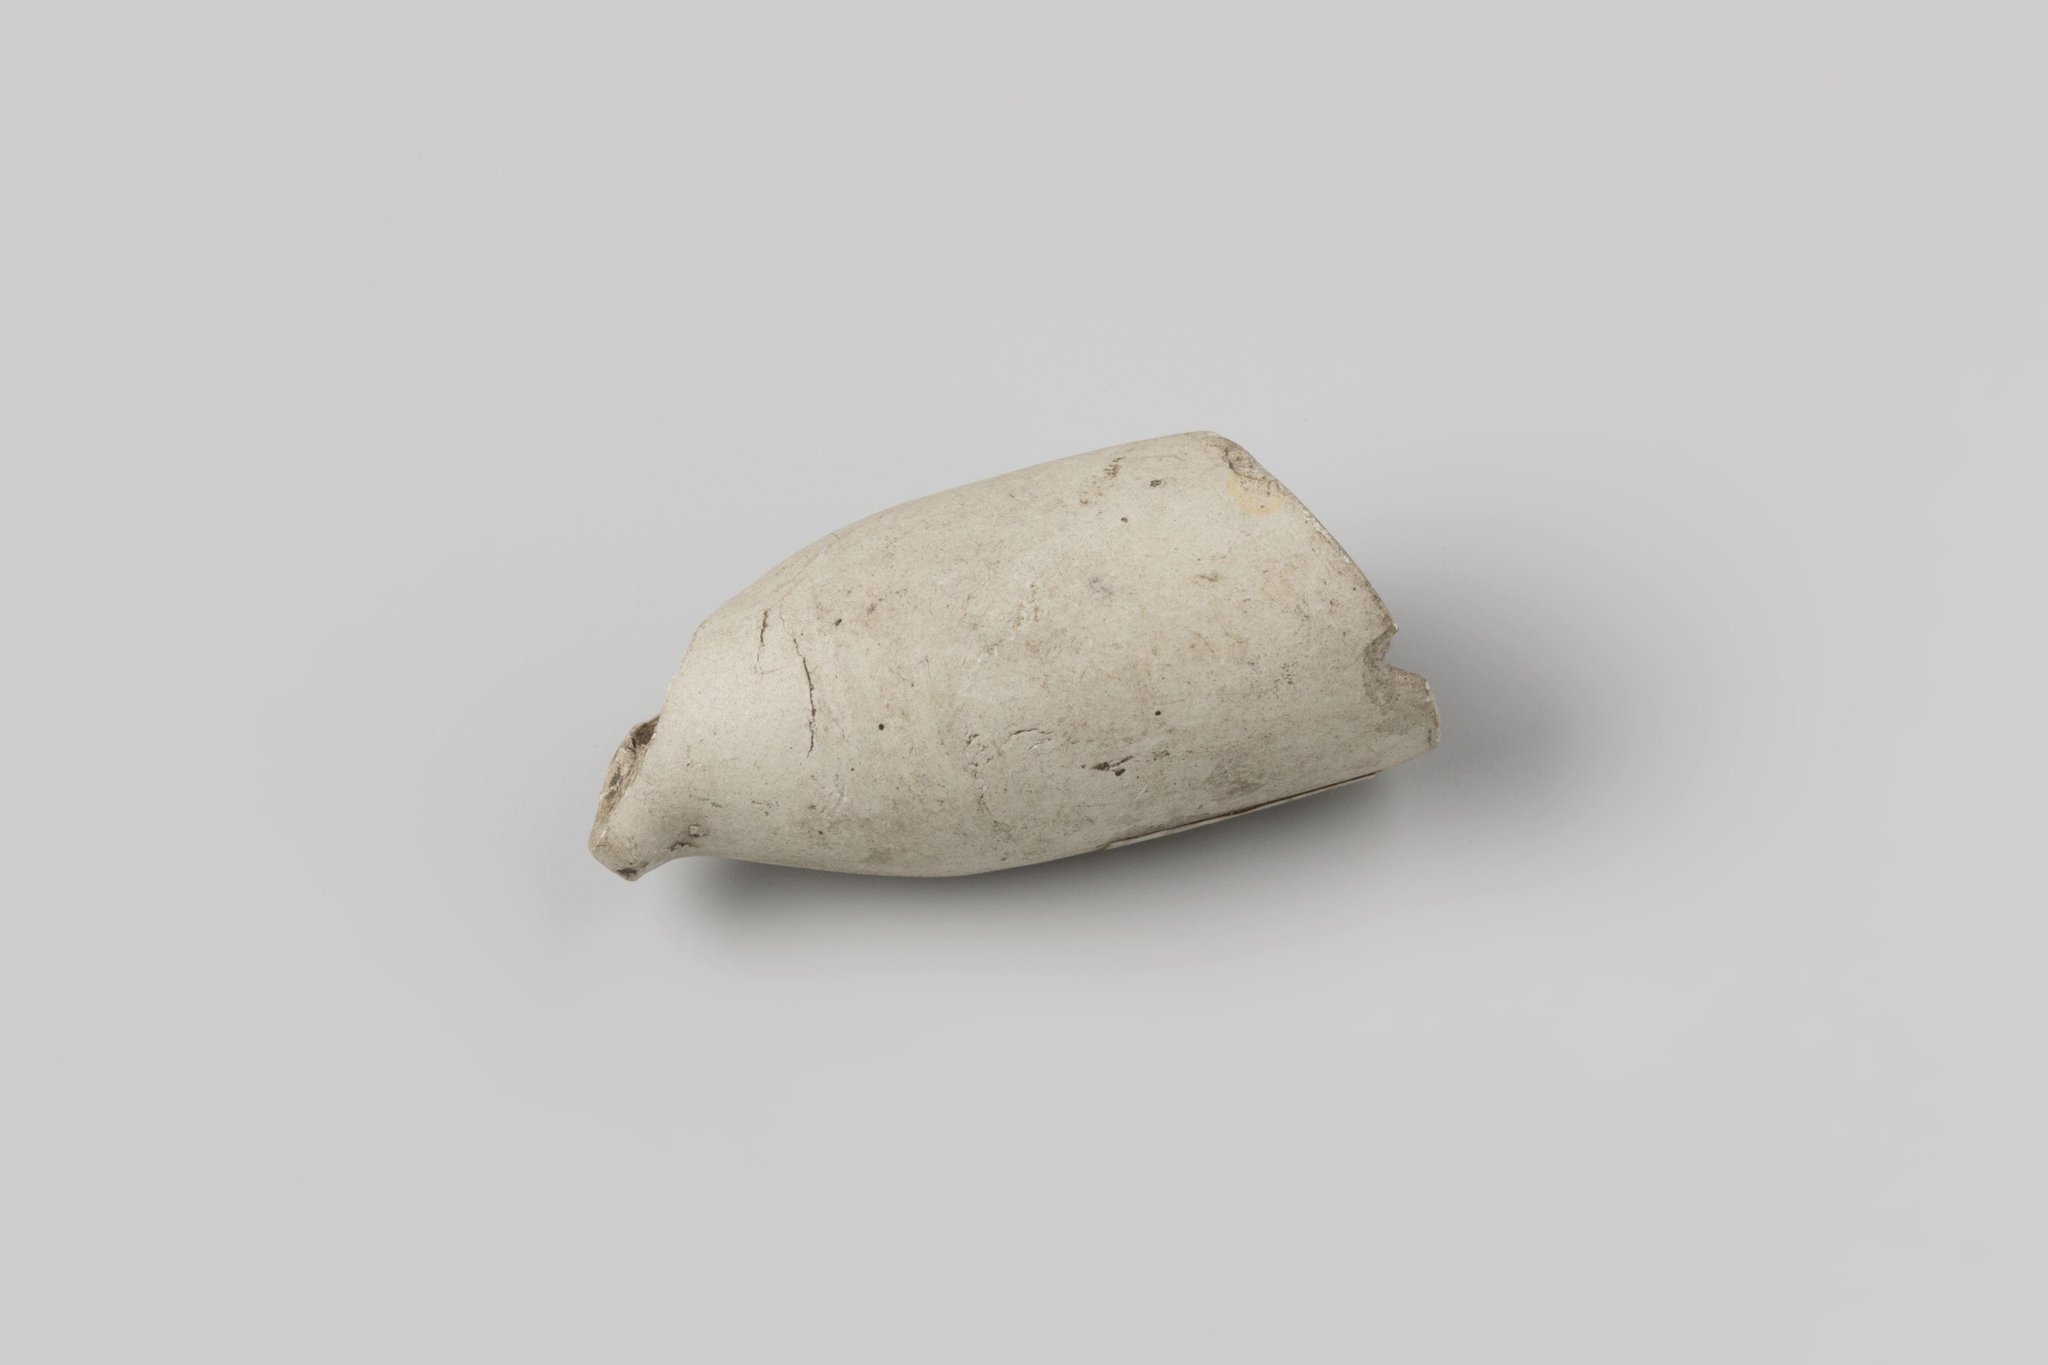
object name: fragment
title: Fragment pijpenkop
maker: Anonymous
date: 1650-1750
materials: clay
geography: netherlands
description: Fragment pijpenkop. Van de opgravingen op de Hofstede Arentsburg 1827-1831 onder toezicht van Professor Reuvens.